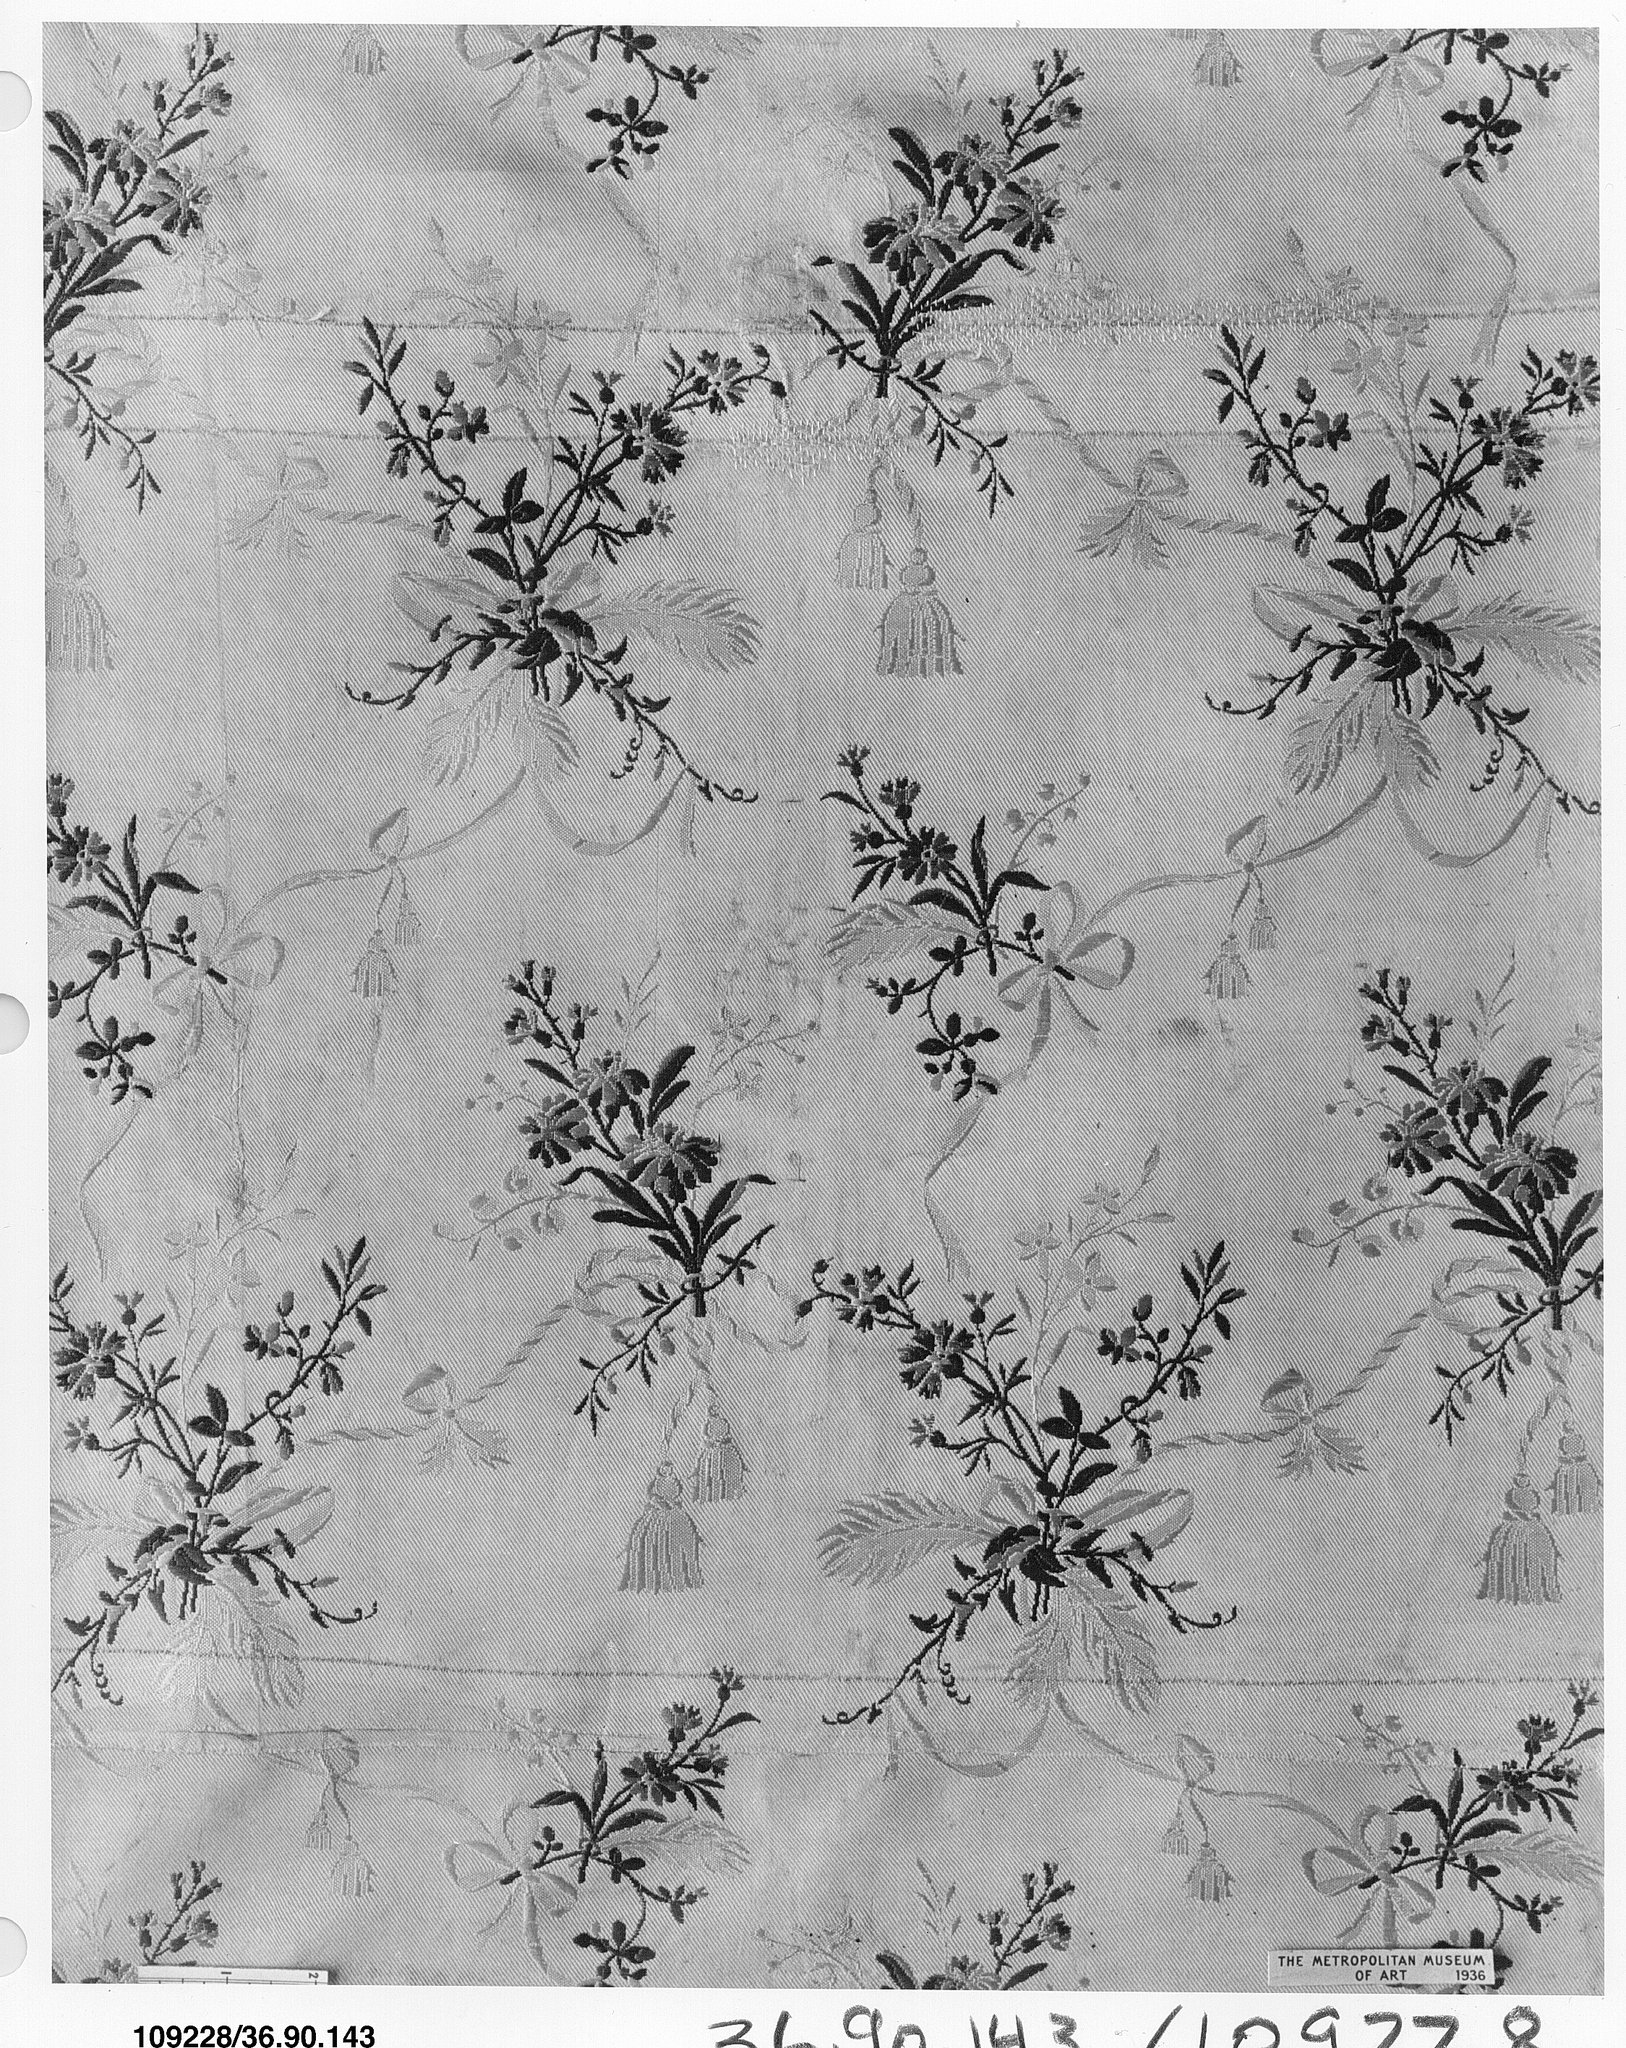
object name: piece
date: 1760-1770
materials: silk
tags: flowers,leaves